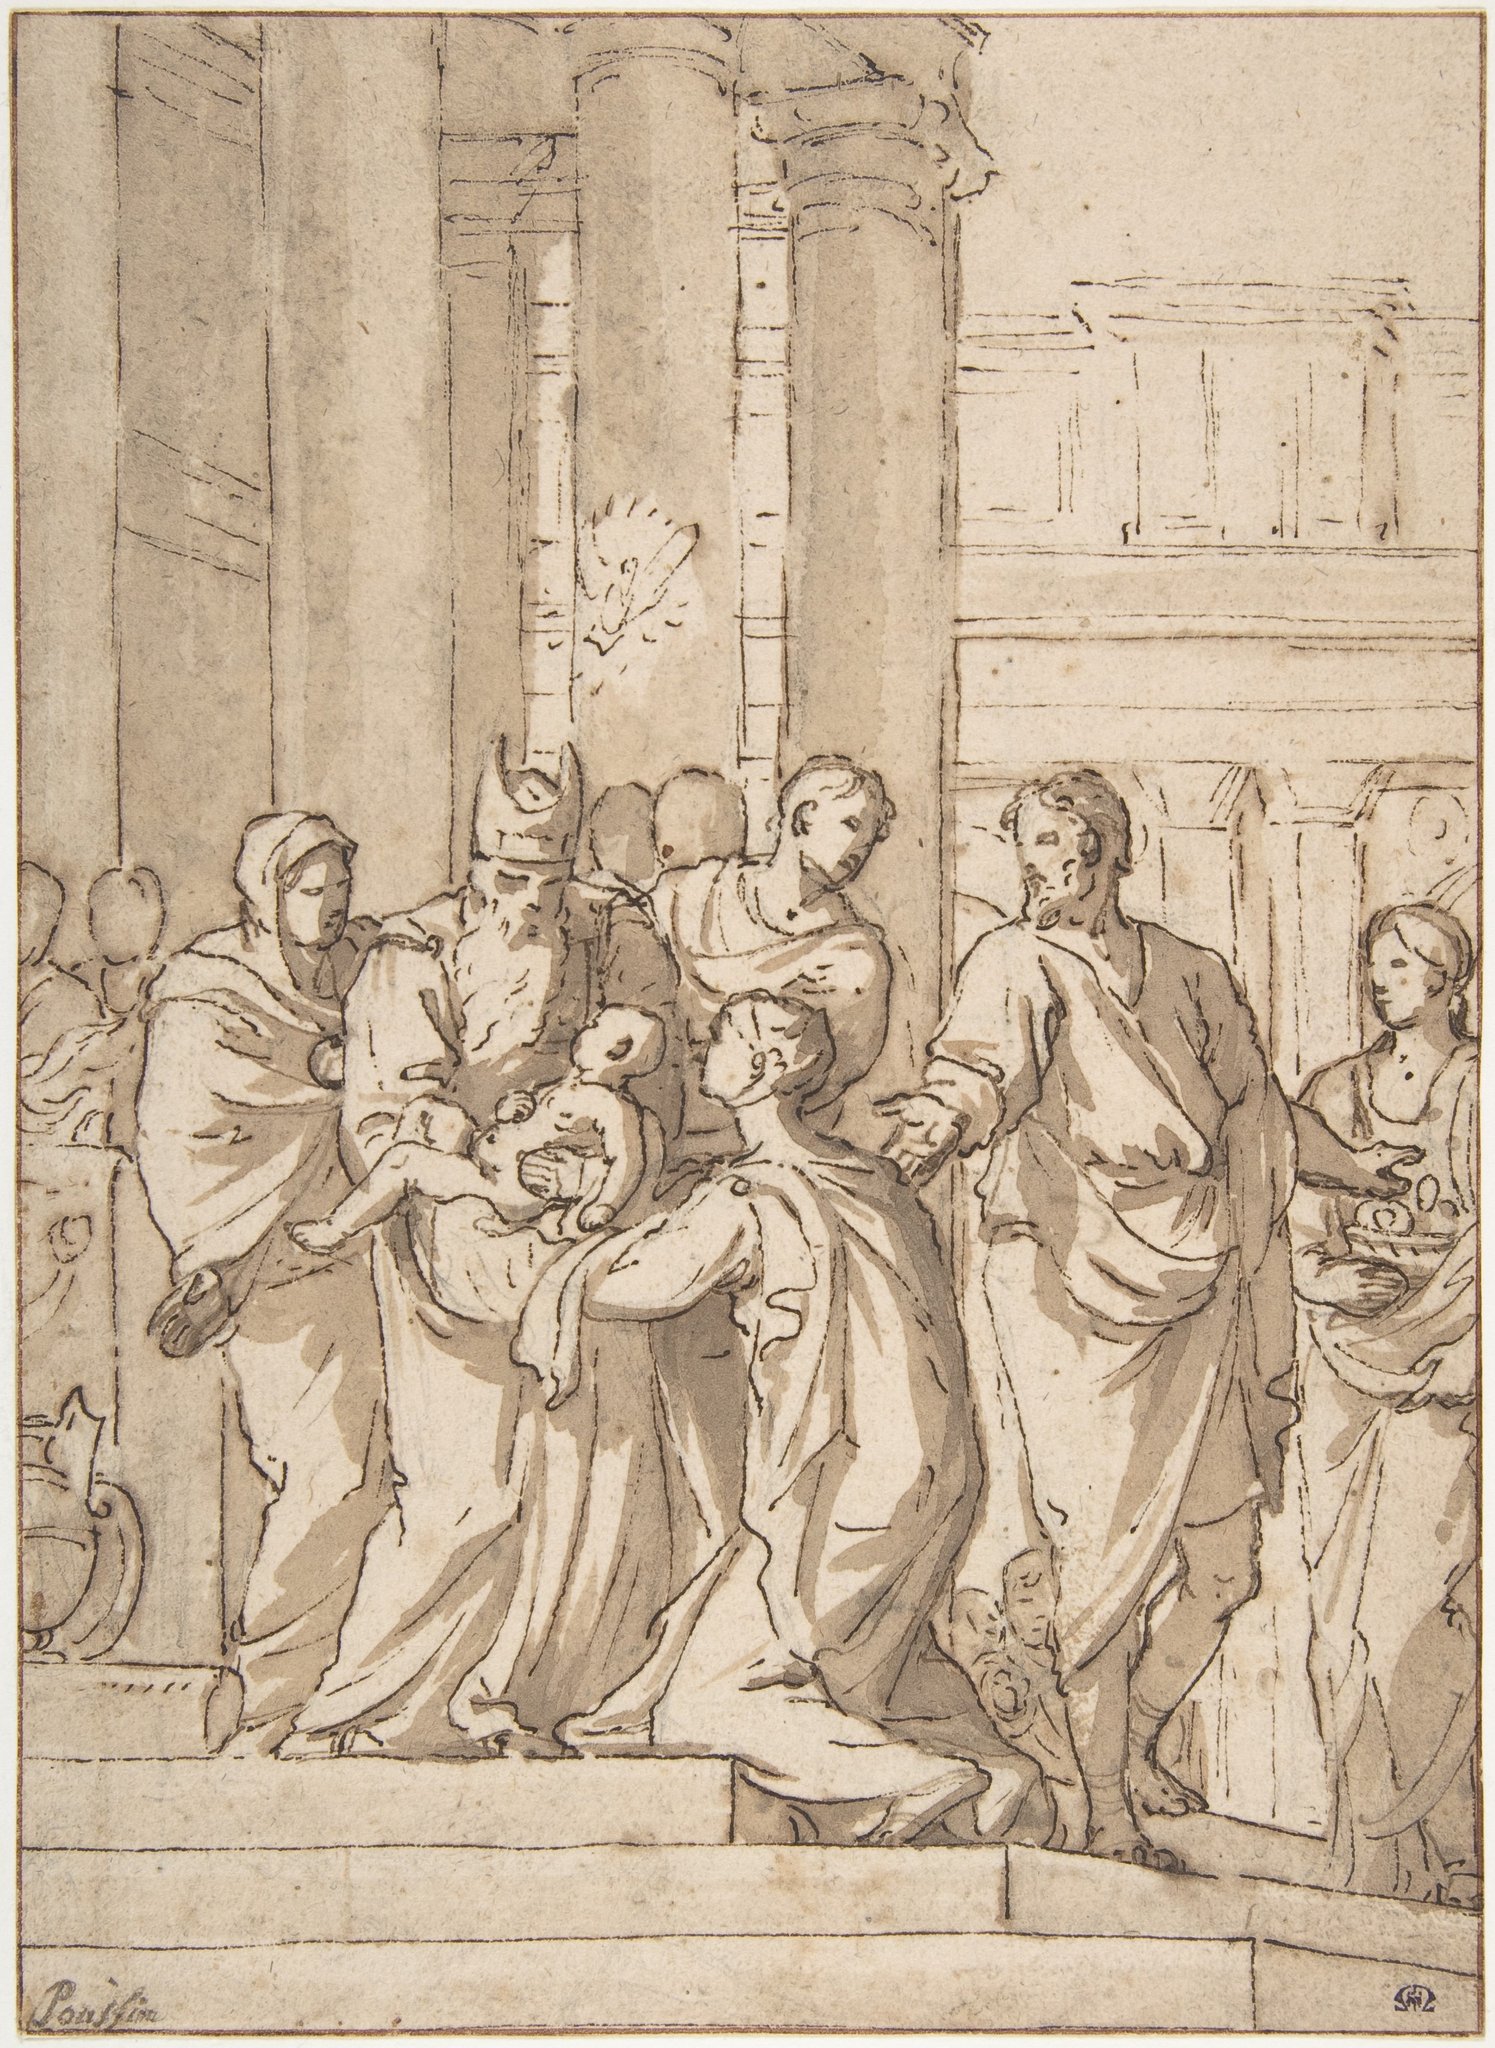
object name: drawing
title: Presentation of the Infant Jesus in the Temple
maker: charles mellin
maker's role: artist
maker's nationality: french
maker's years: 1597-1649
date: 1643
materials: ink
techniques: pen, wash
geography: france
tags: infants,men,women,jesus